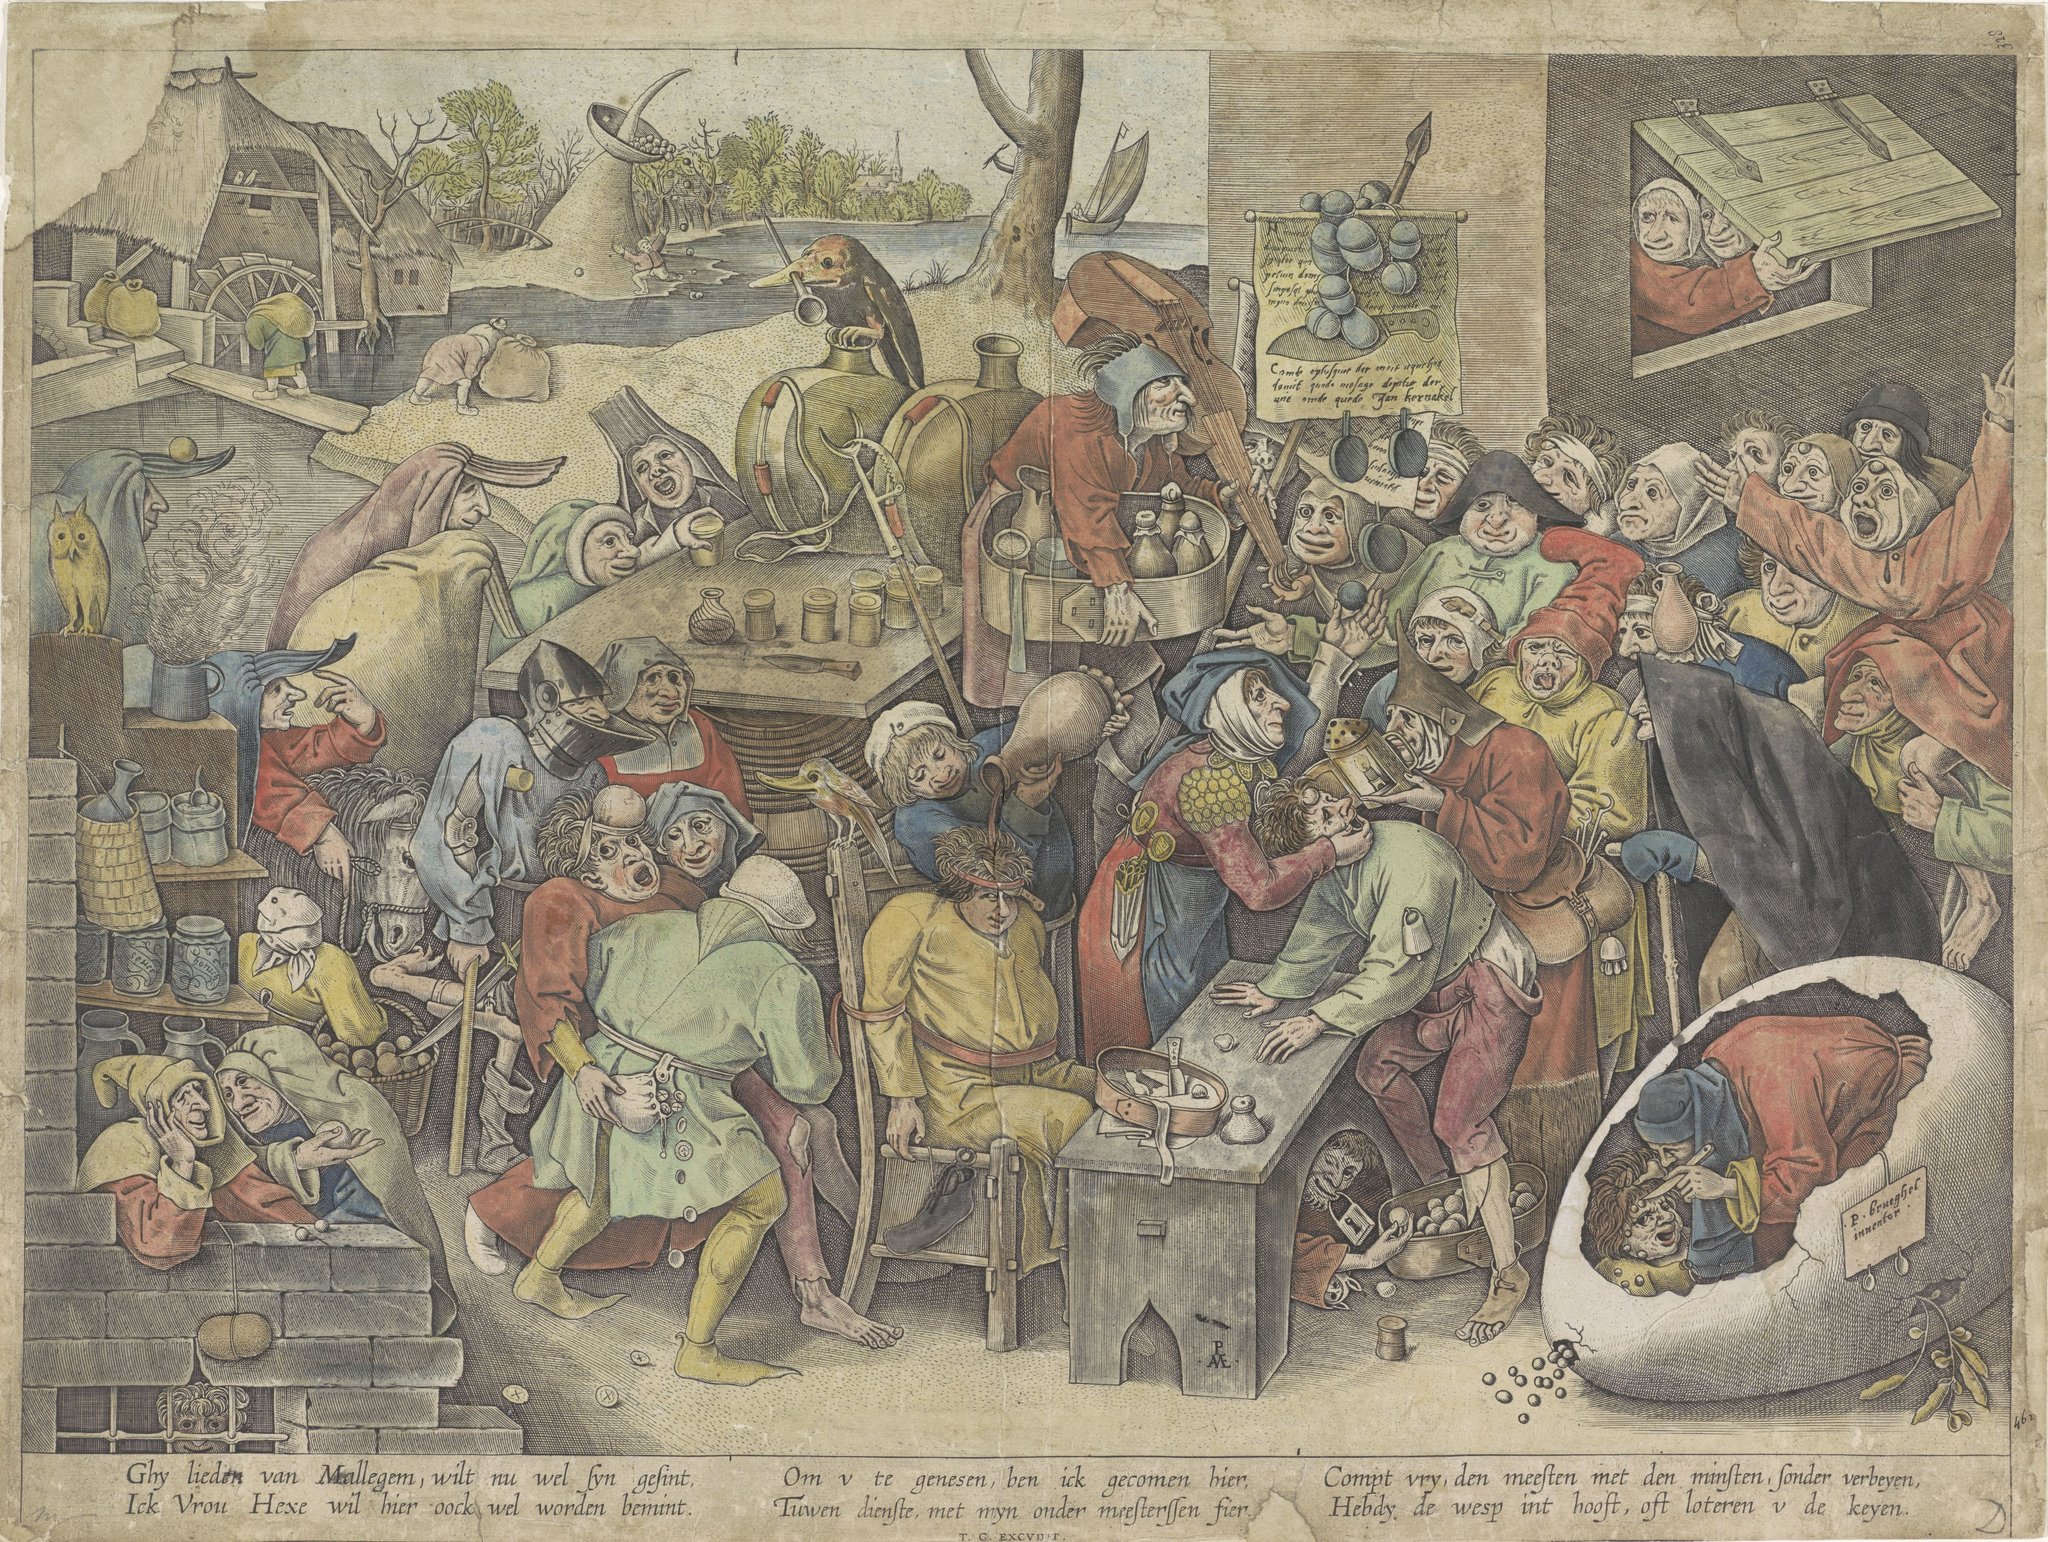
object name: print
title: Keisnijder of de heks van Mallegem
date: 1595-1633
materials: paper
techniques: engraving, hand coloring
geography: antwerp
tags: prison, jail, purse, money-bag, viola, violoncello; double bass, stone-operation, e.g.: by the witch of malleghem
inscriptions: collector's mark: Lugt 2228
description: De keisnijder of de heks van Mallegem. Te midden van een groep dwazen voert een kwakzalver bij het licht van een lantaarn een operatie uit waarbij een kei uit het hoofd van de patient wordt gesneden. Rechts een schreeuwende vrouw gezeten op de schouders van een oude vrouw. Rechts voor het snijden van keien in een groot ei. Op de achtergrond een watermolen en fantastische wezens. Onder de voorstelling drie tweeregelige verzen in het Nederlands.